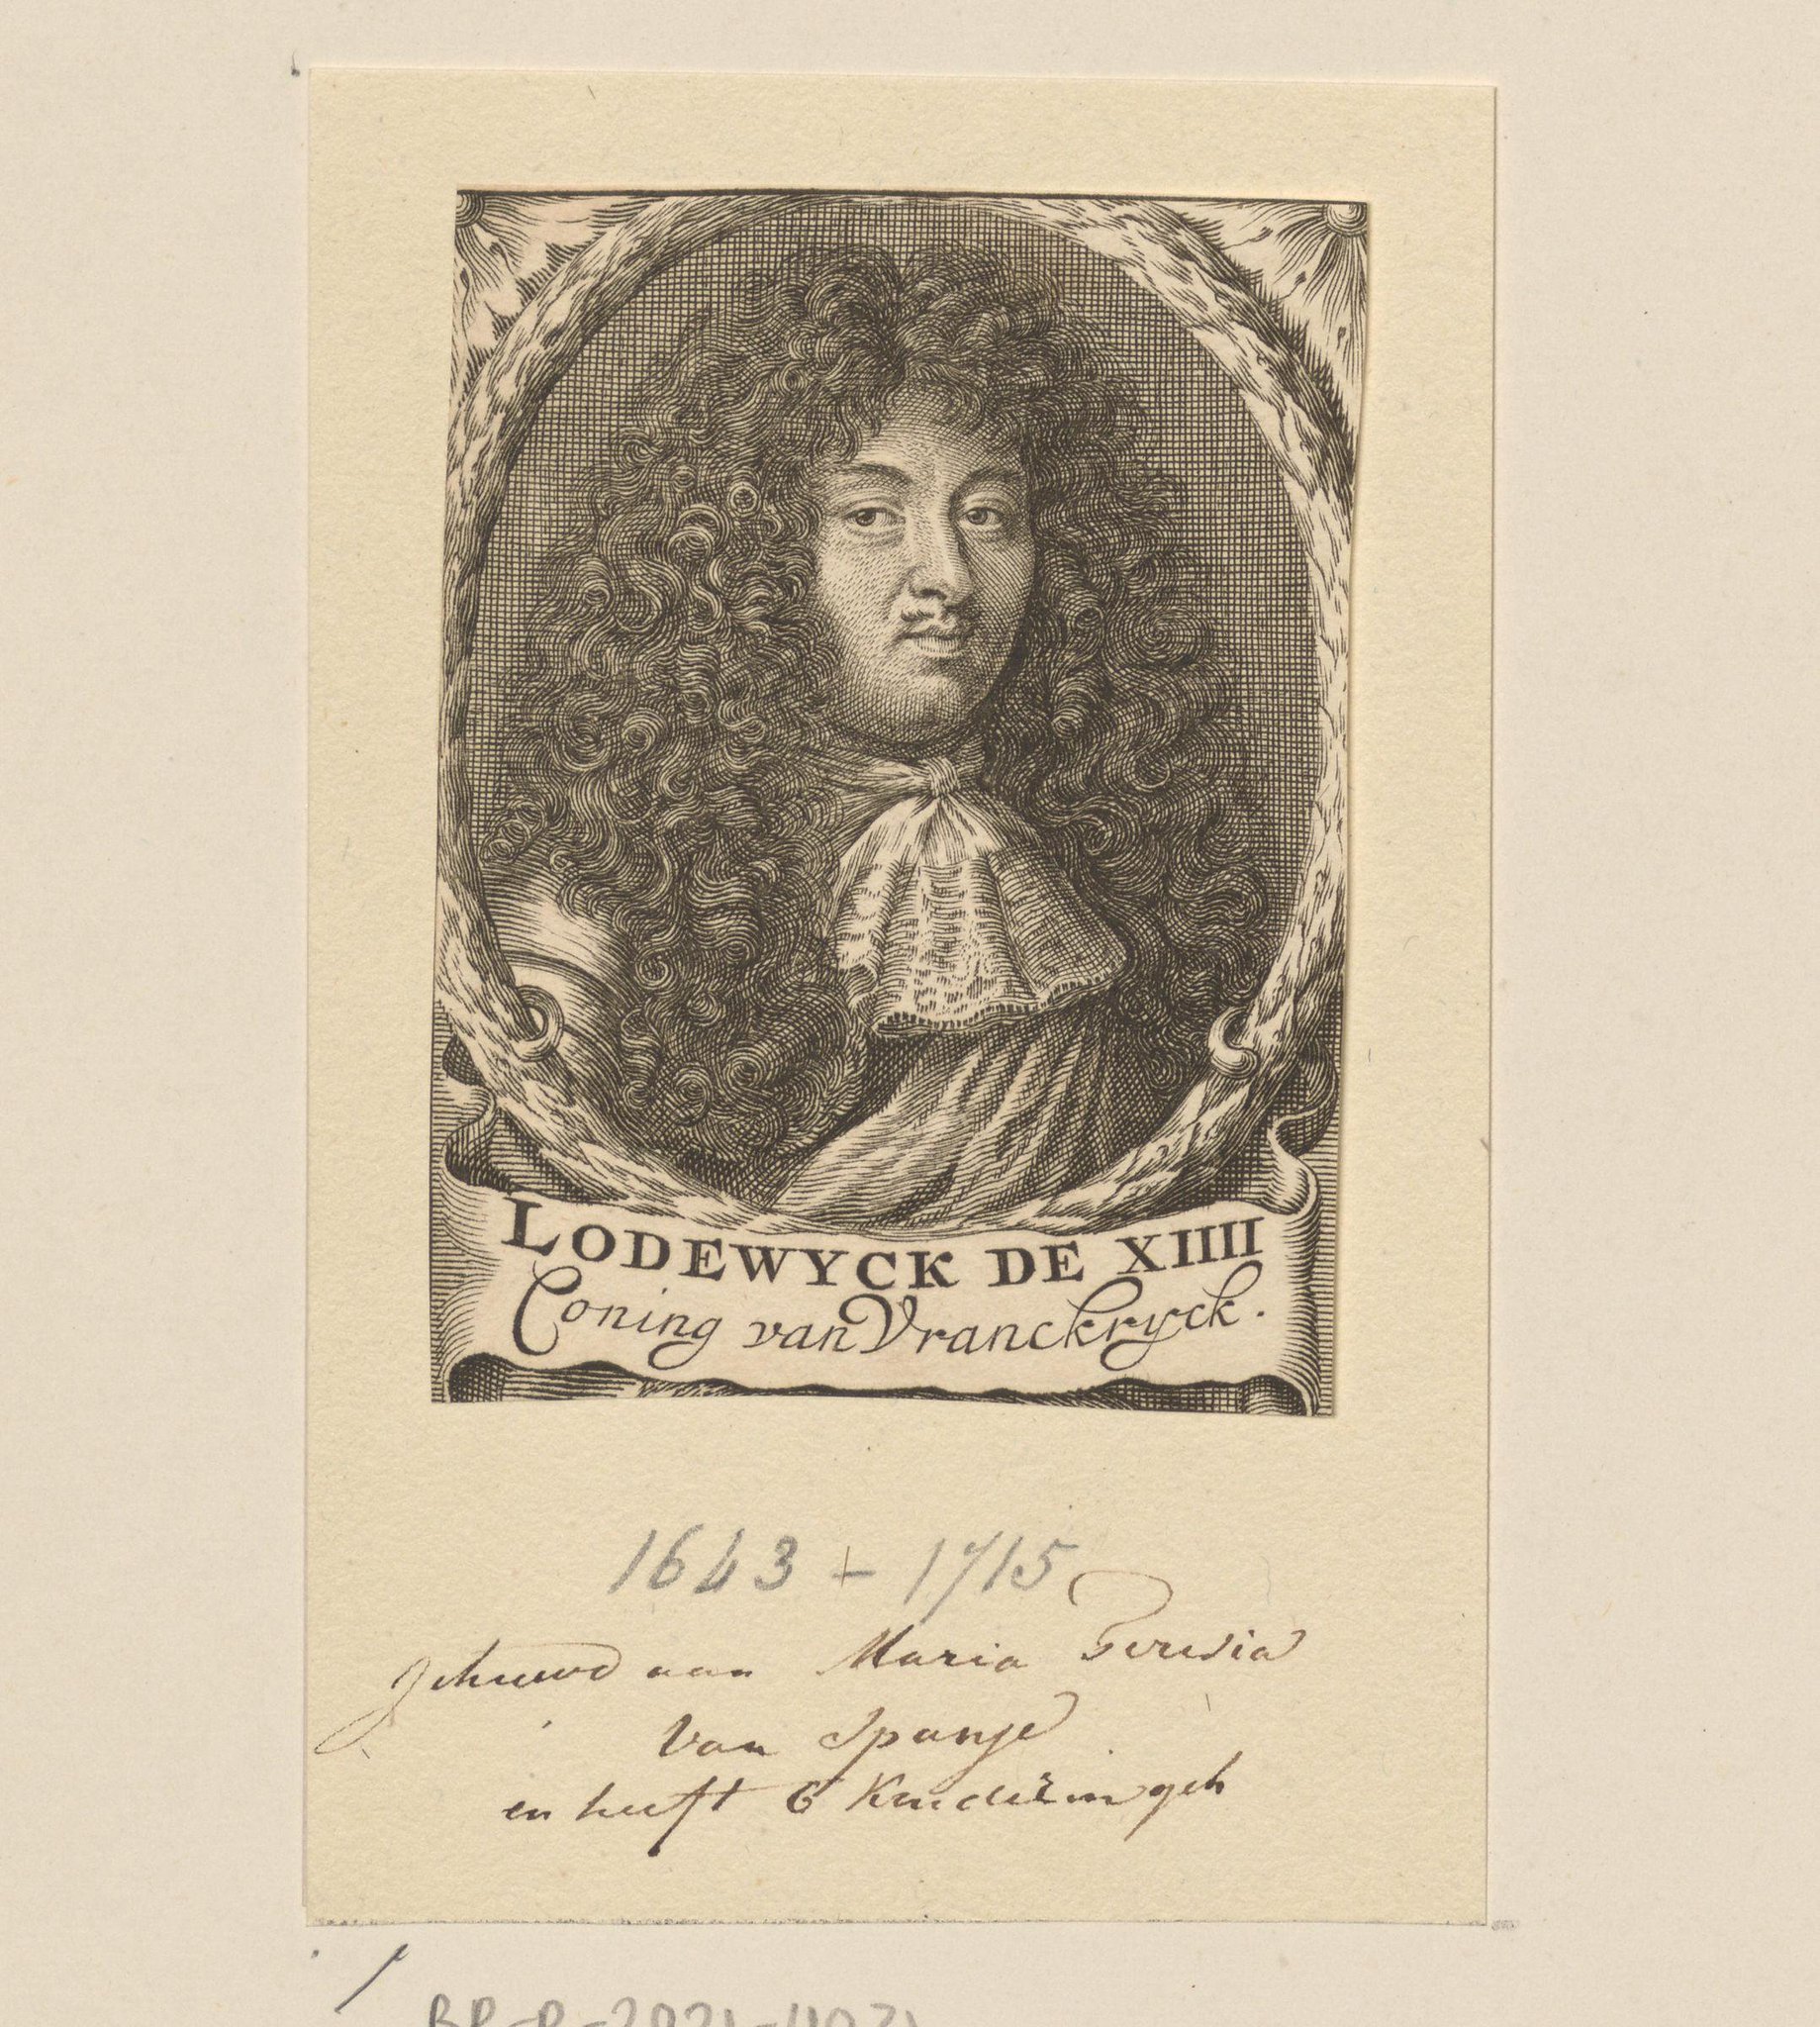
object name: print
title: Portret van Lodewijk XIV van Frankrijk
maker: Anonymous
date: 1700-1750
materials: paper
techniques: engraving, etching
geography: low countries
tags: lodewijk xiv (koning van frankrijk), historical persons, king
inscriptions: inscription: ‘gehuwd aan Maria Teresia/ van Spanje/ en heeft 6 kinderen geh.’